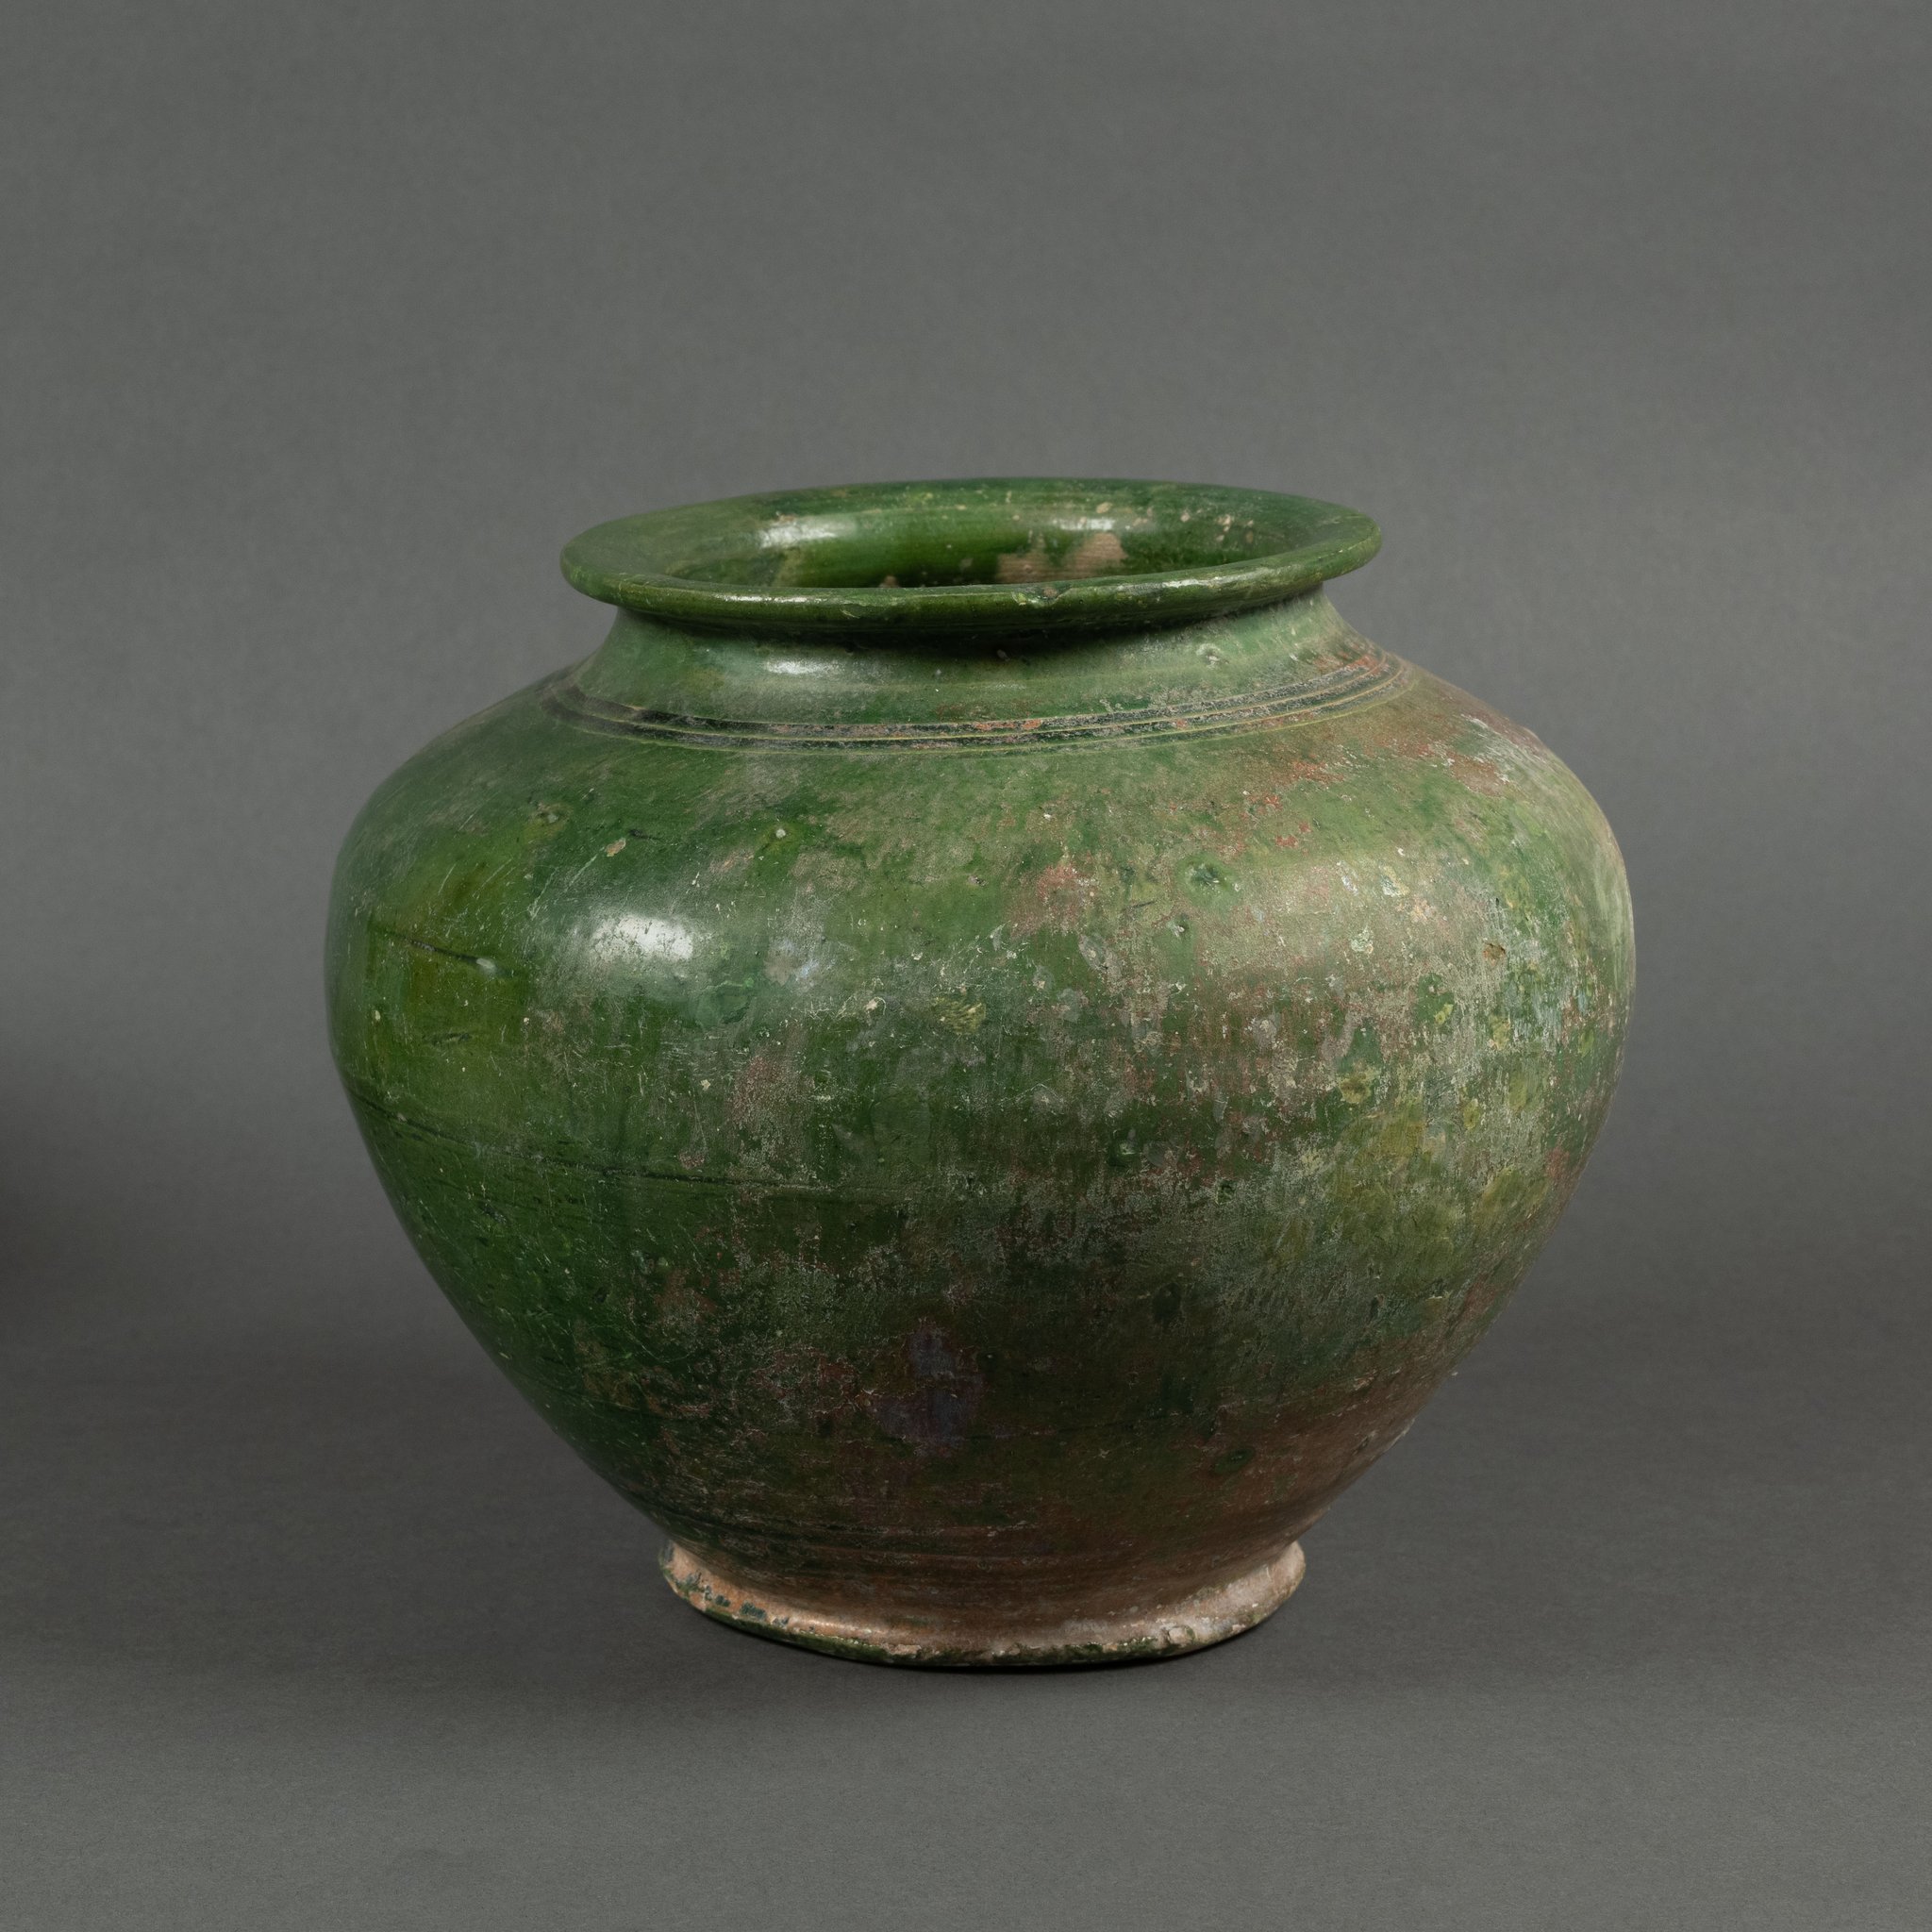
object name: jar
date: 701-1000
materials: earthenware, glaze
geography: iran